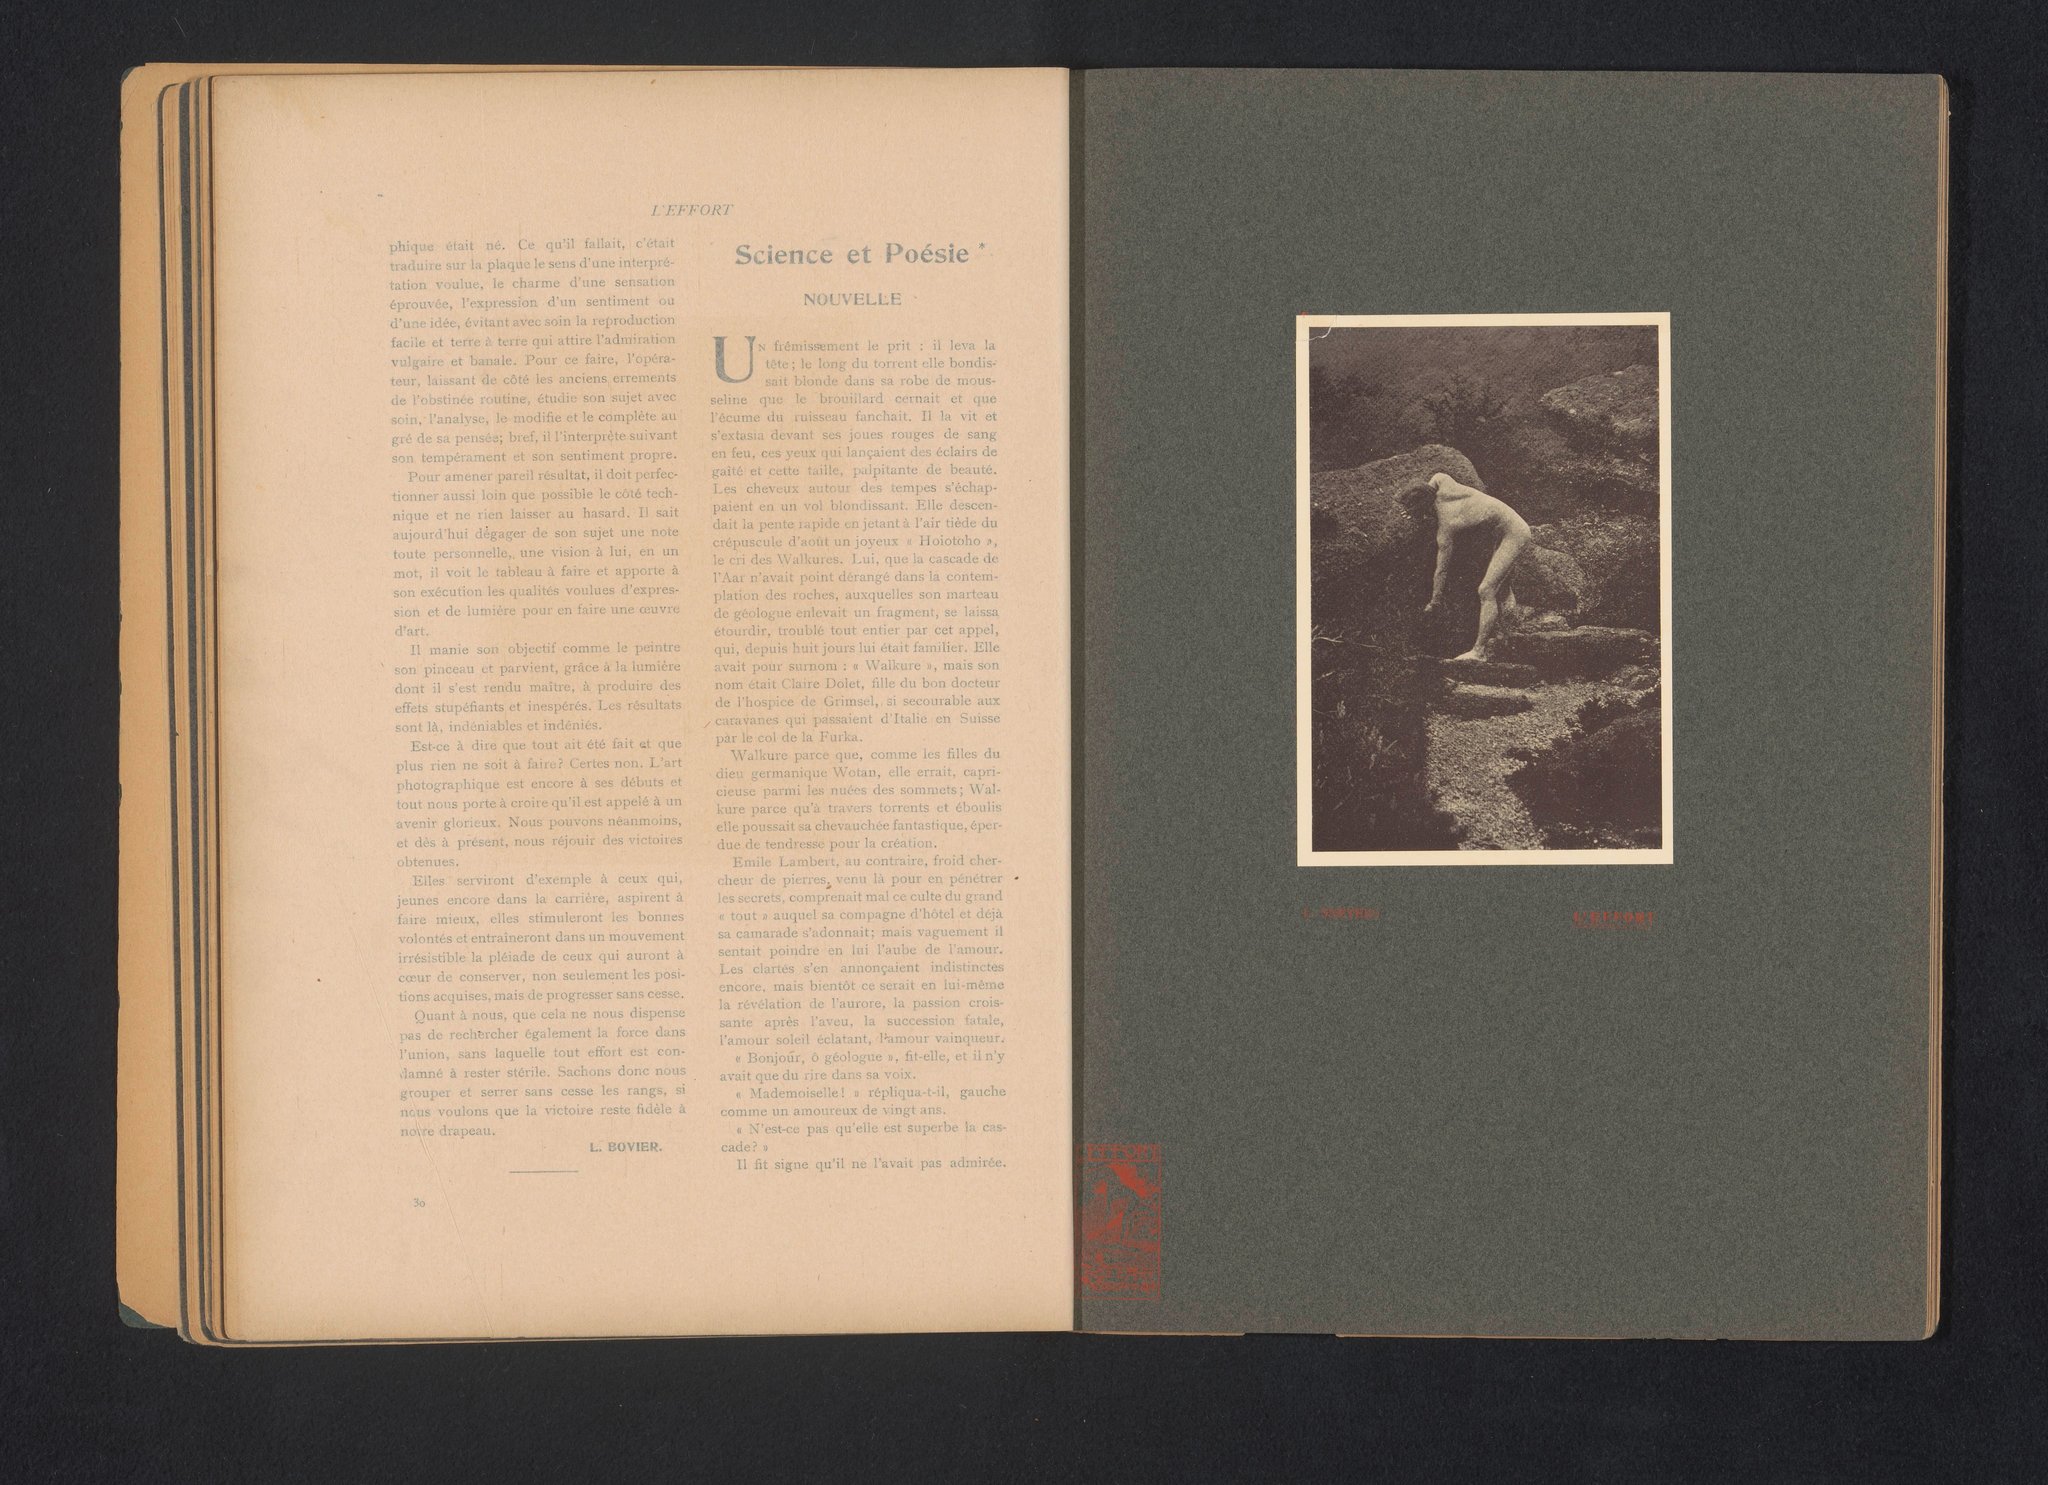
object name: page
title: Naakte man beklimt een rotsachtige heuvel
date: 1896-1901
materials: paper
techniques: autotype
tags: climbing, rock-formations, man (showing himself) undressed, quasi-nude